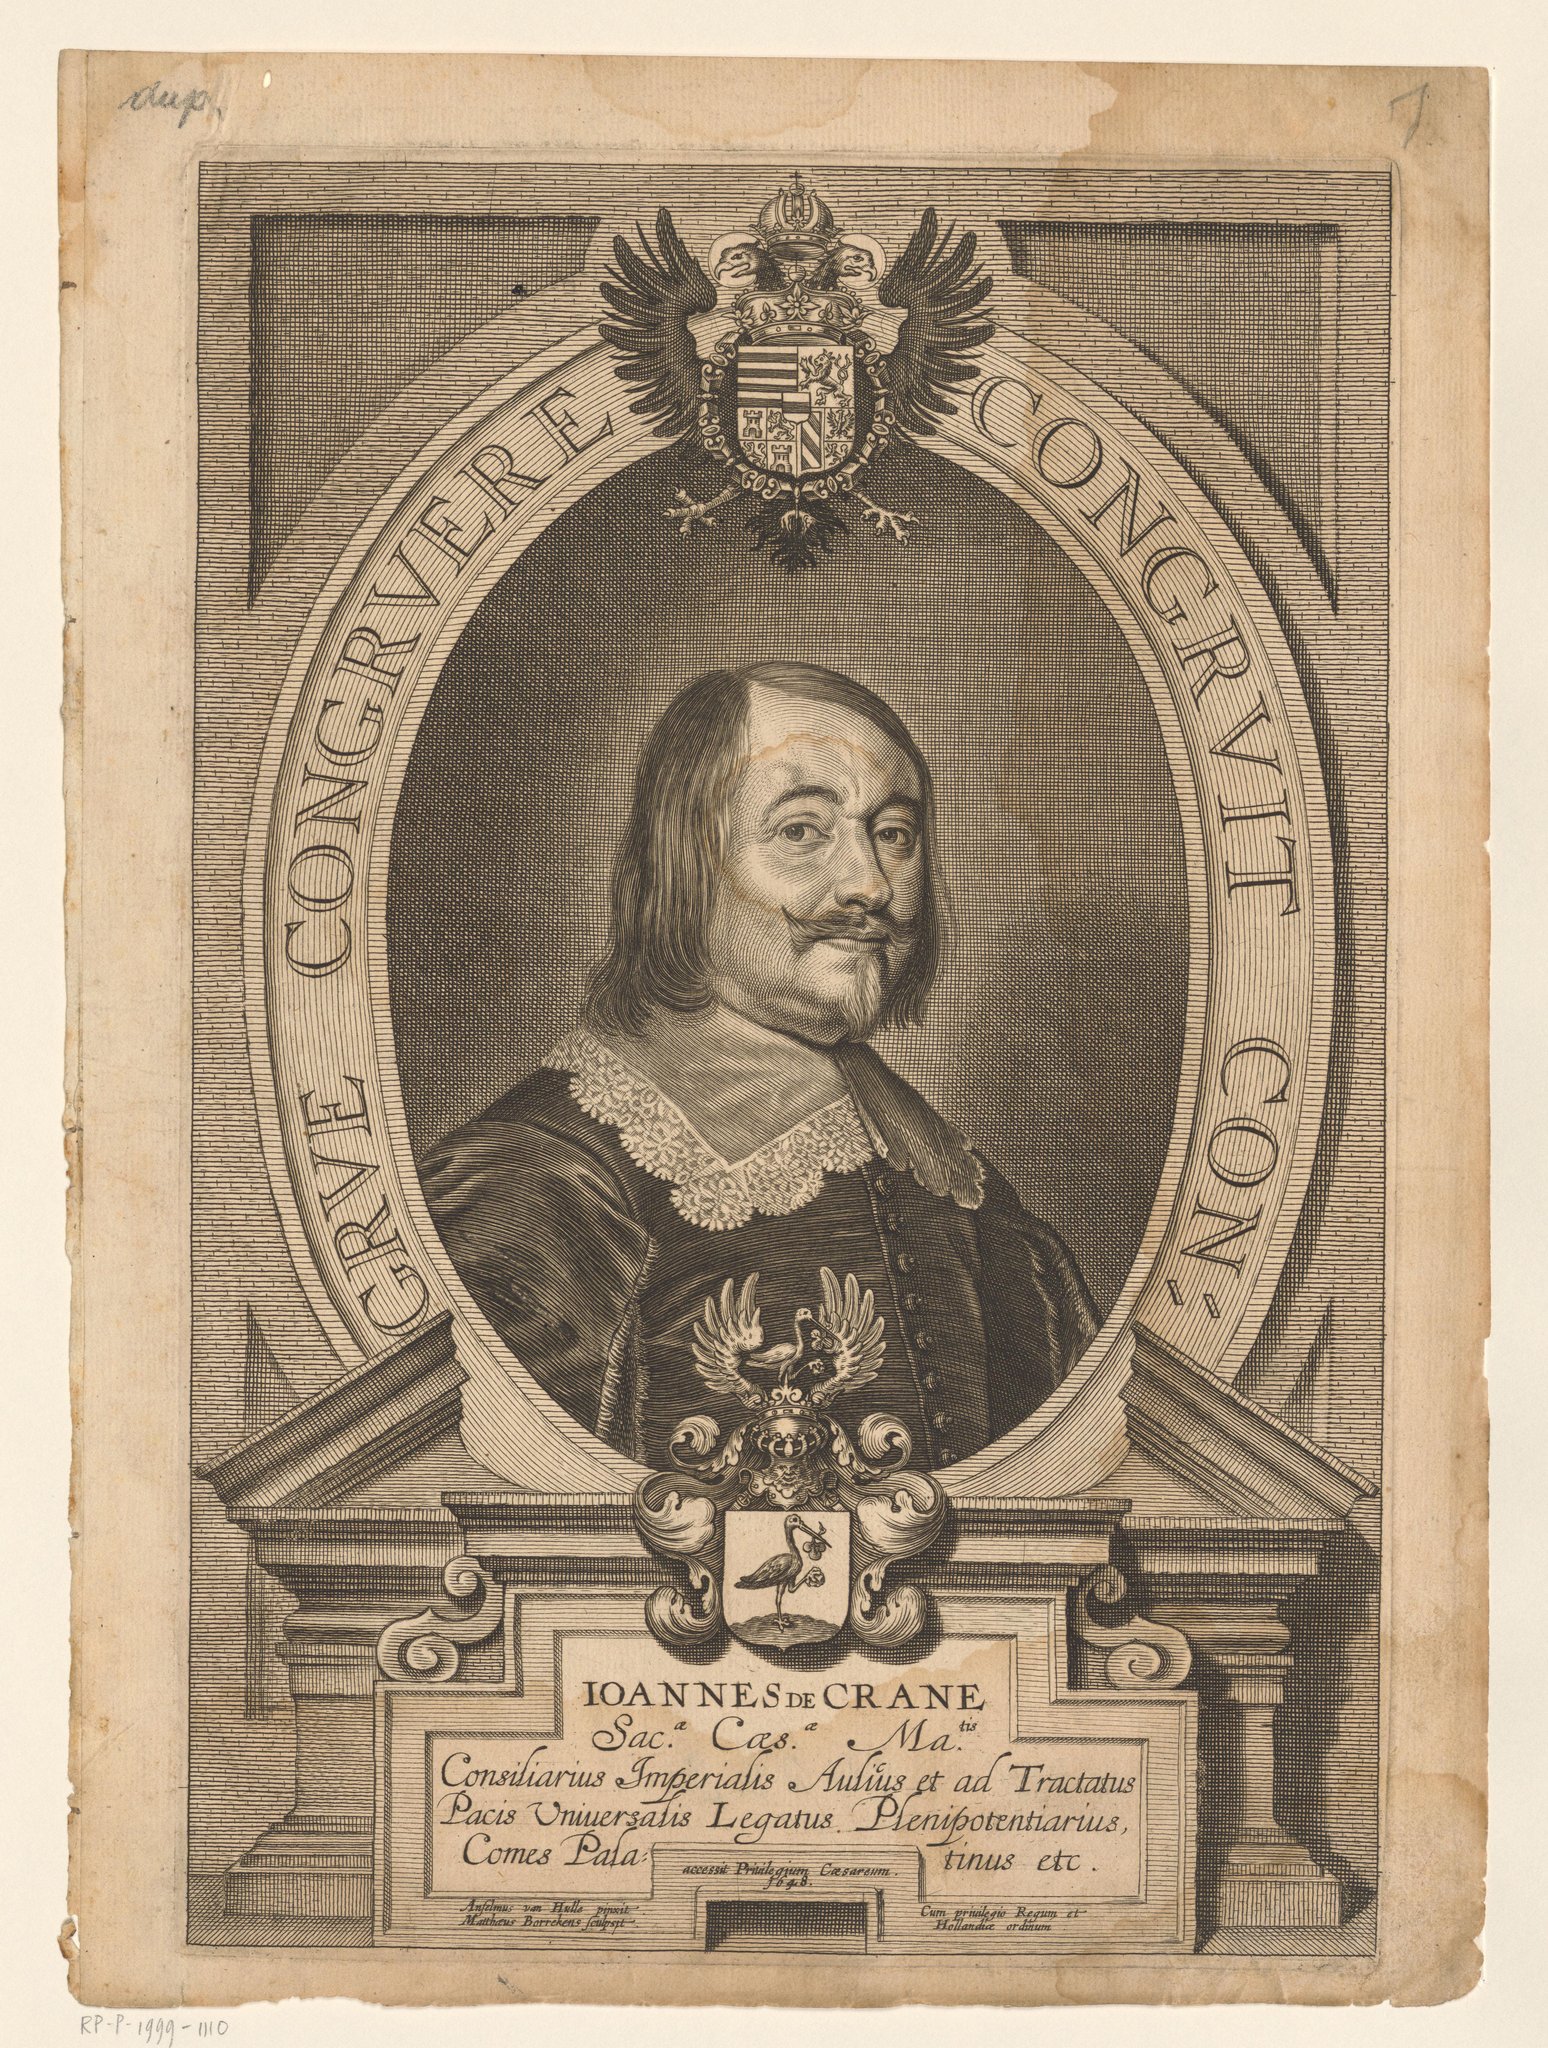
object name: print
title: Portret van Johann Krane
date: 1648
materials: paper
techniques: engraving, etching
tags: vienna, historical persons, armorial bearing, heraldry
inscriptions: collector's mark: Lugt 2228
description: Boven en onder het portret zijn wapenschild.